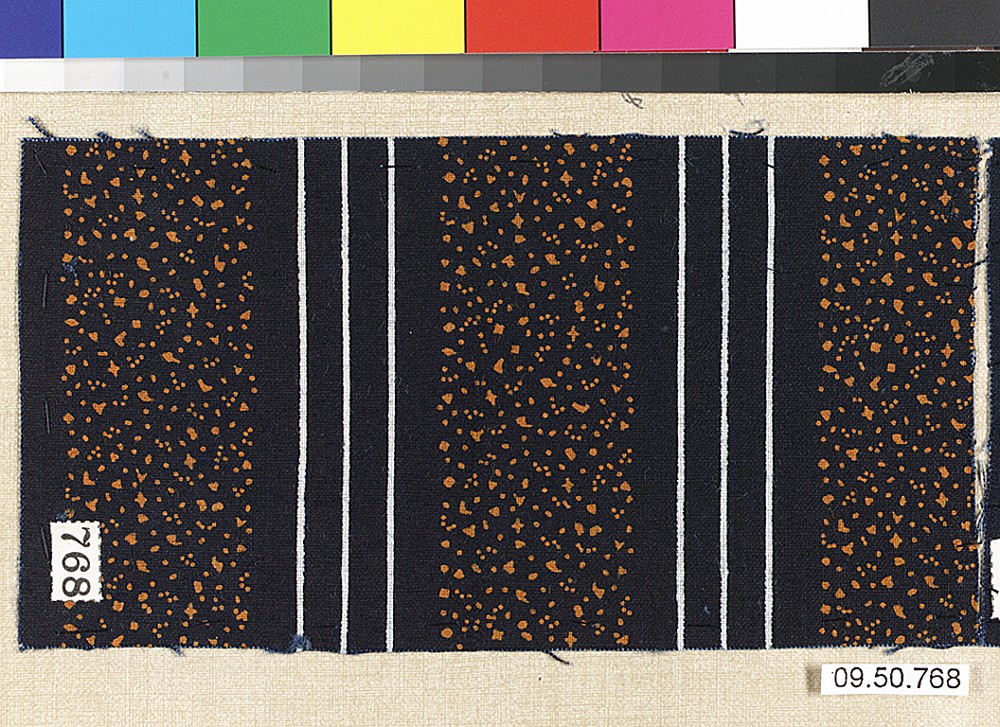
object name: piece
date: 1801-1900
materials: cotton